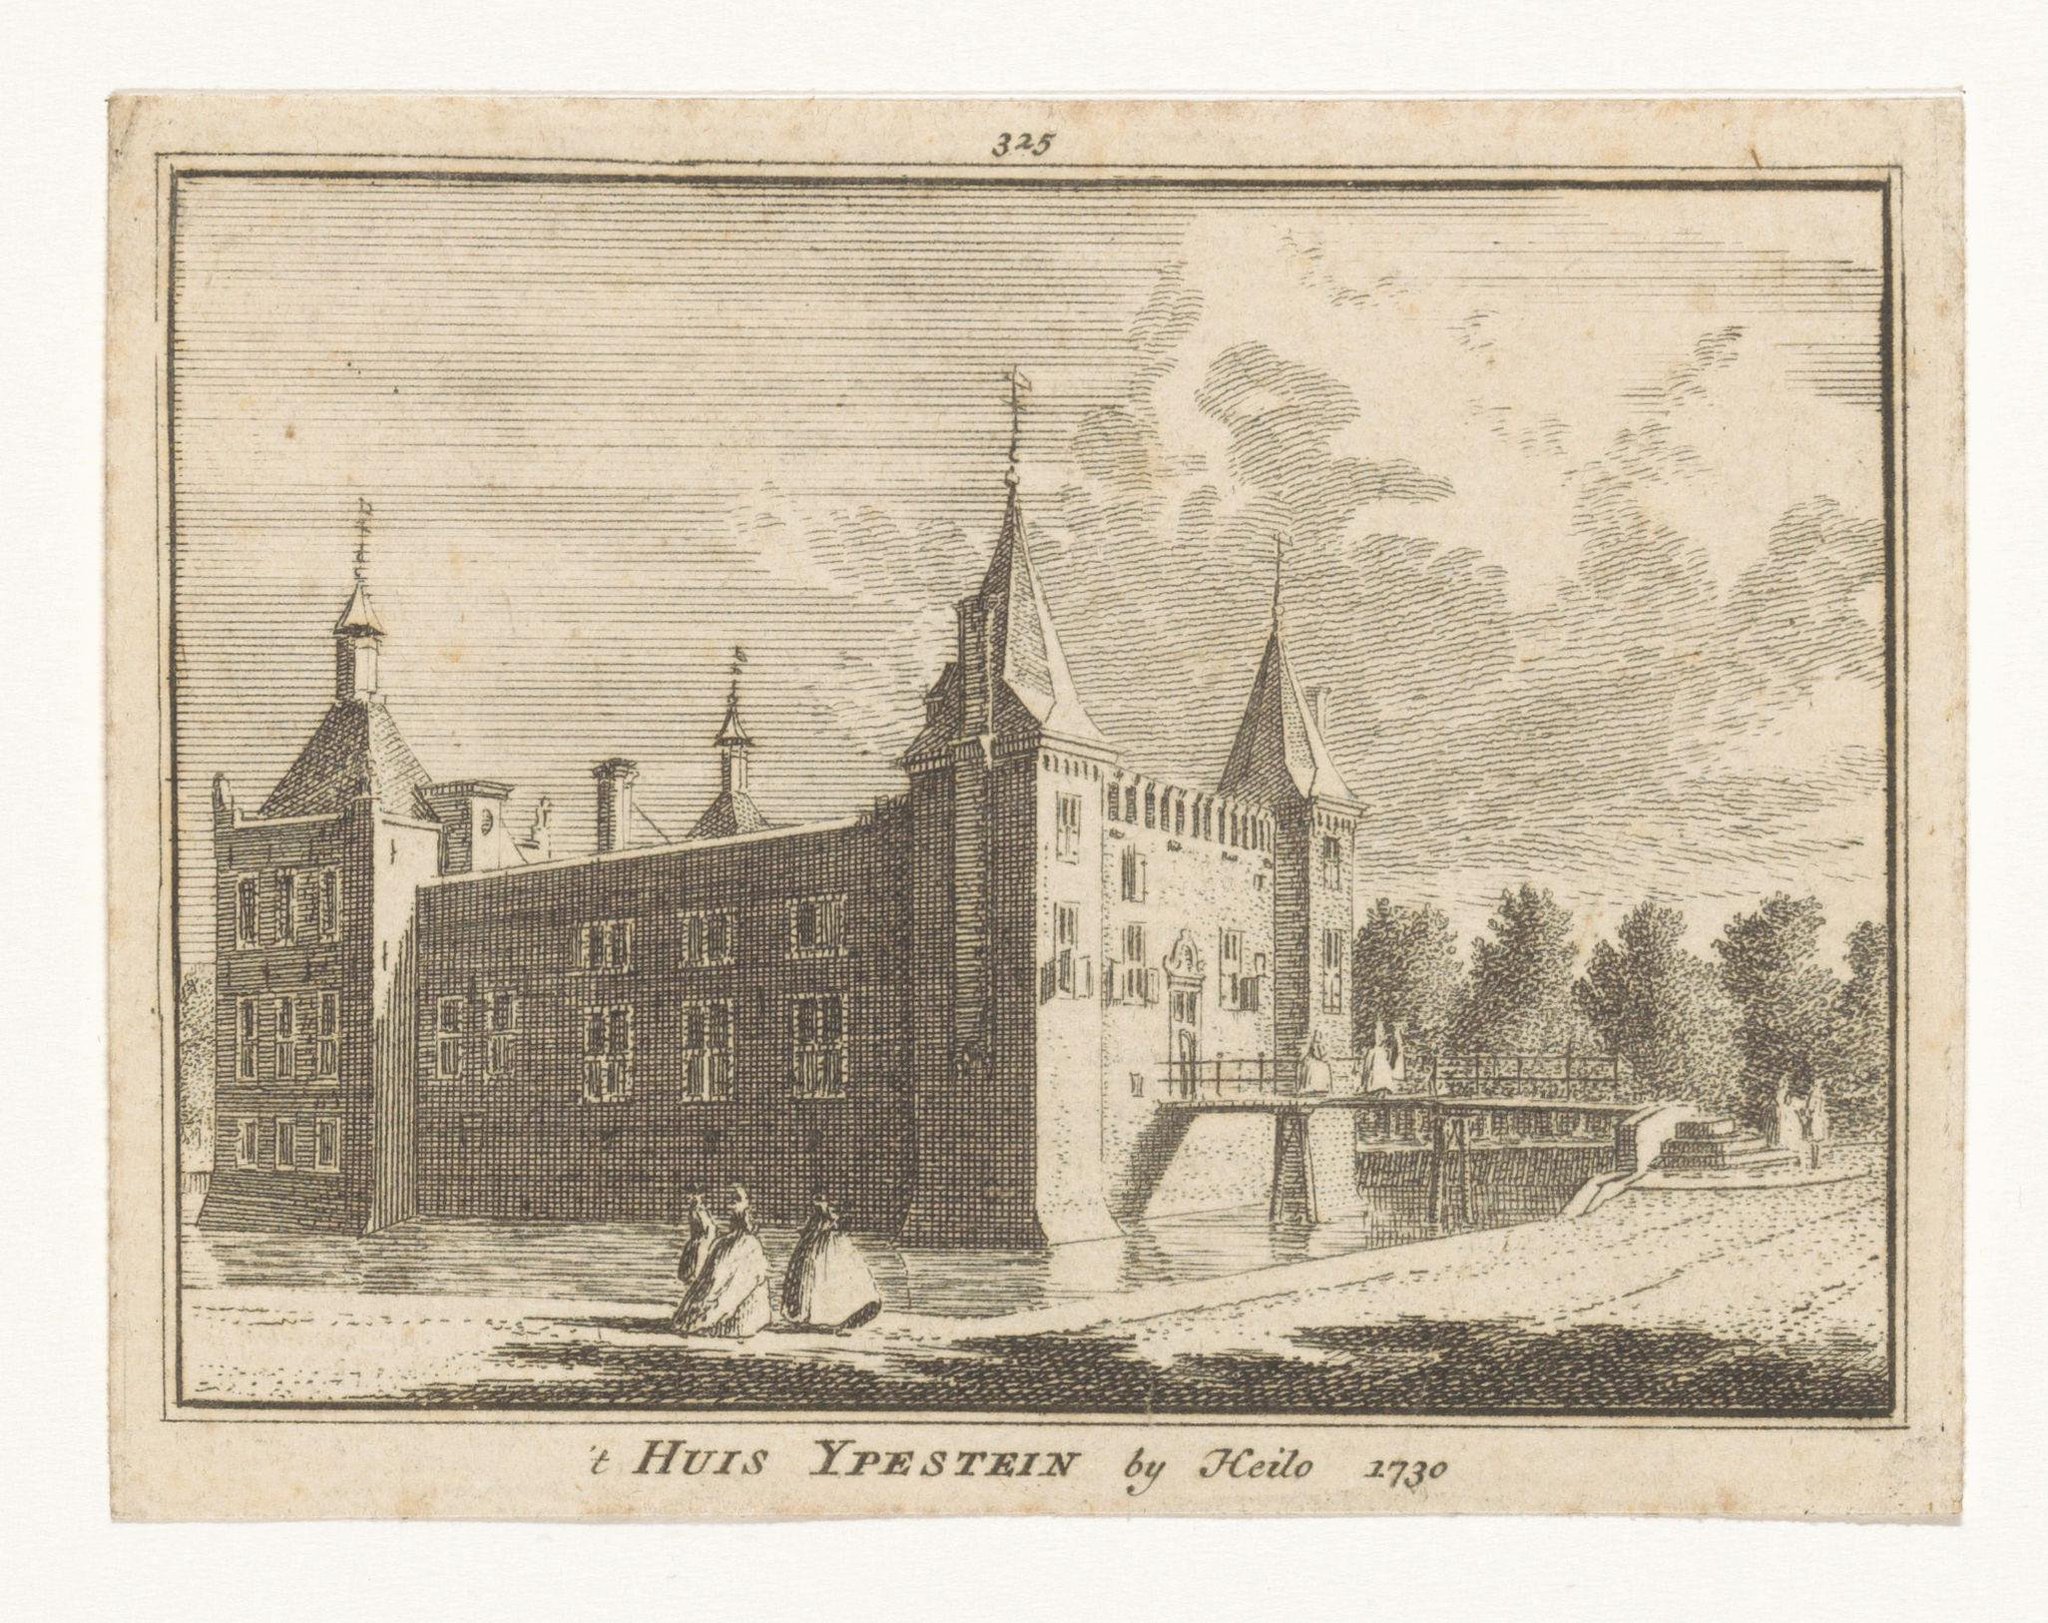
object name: book illustration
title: Gezicht op Kasteel Ypestein, 1730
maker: hendrik spilman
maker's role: draughtsman, painter, print maker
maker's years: 1721-1784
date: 1752-1792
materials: paper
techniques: engraving, etching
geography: haarlem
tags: castle, bridge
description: Prent ook gebruikt in: Het verheerlykt Nederland of kabinet van hedendaagsche gezigten van steden, dorpen (…). 9 delen. Amsterdam: Isaak Tirion en weduwe Isaak Tirion, 1745-1774, dl. 4 (1752), ill. 325. Of in: Nederlandsche tafereelen; of eene keurige verzameling van negen honderd fraaije gezigten van steden, dorpen, sloten, oudheden (….). 9 delen. Amsterdam: Jan de Groot, 1792, dl. 4, ill. 325. Uit welke druk het huidige exemplaar precies komt is niet na te gaan.